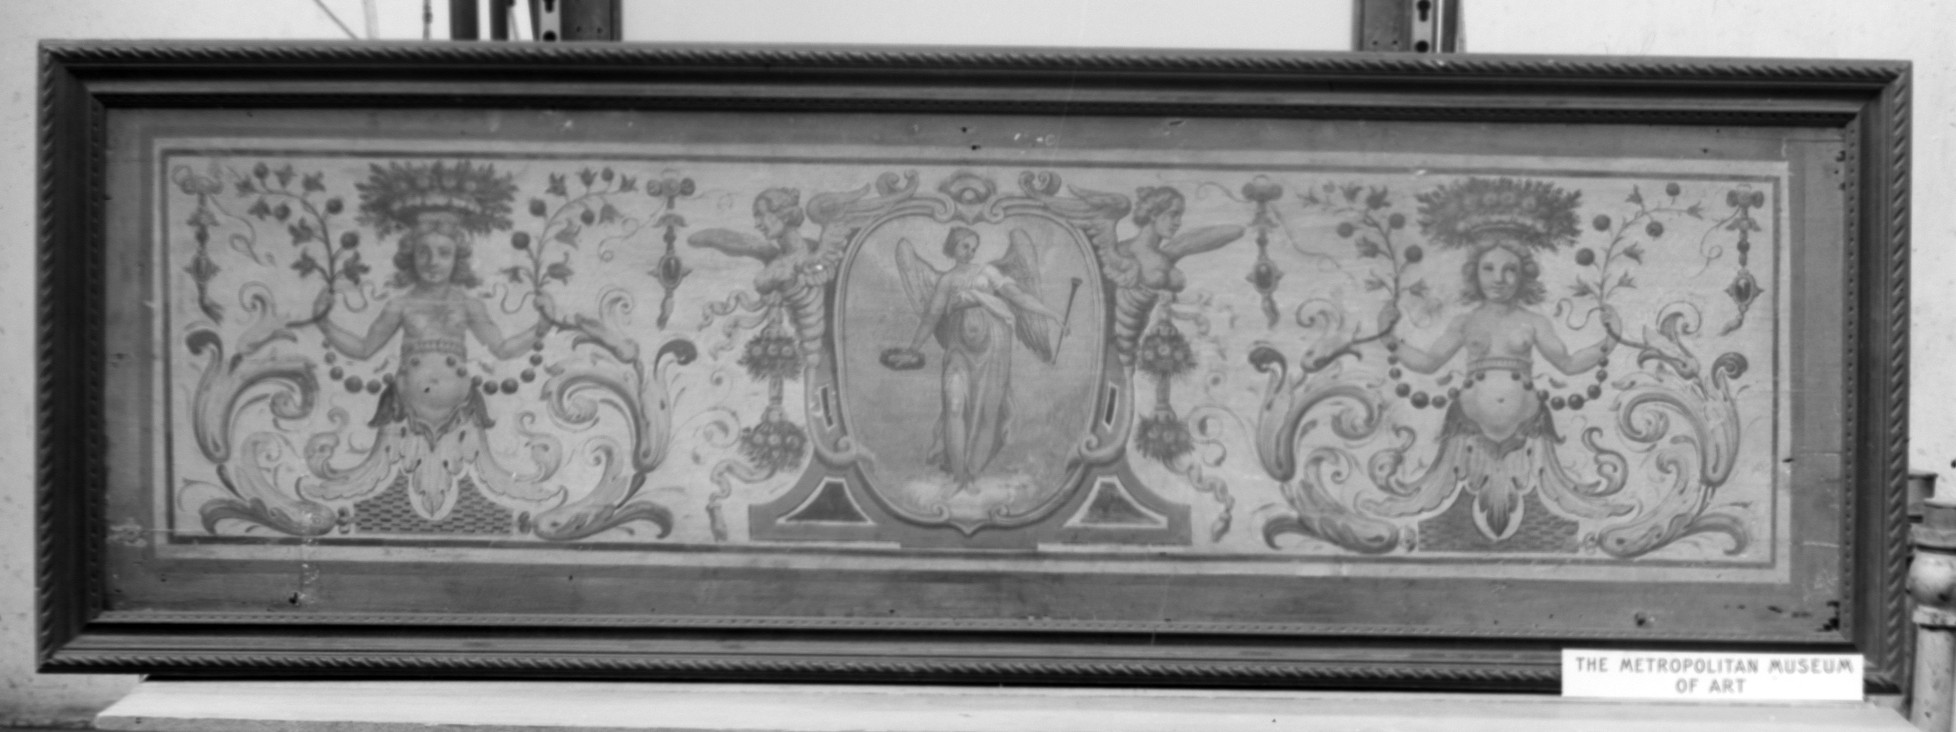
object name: harpsichord top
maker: il poccetti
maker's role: artist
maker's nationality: italian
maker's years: 1548-1612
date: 1567-1600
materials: wood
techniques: painting